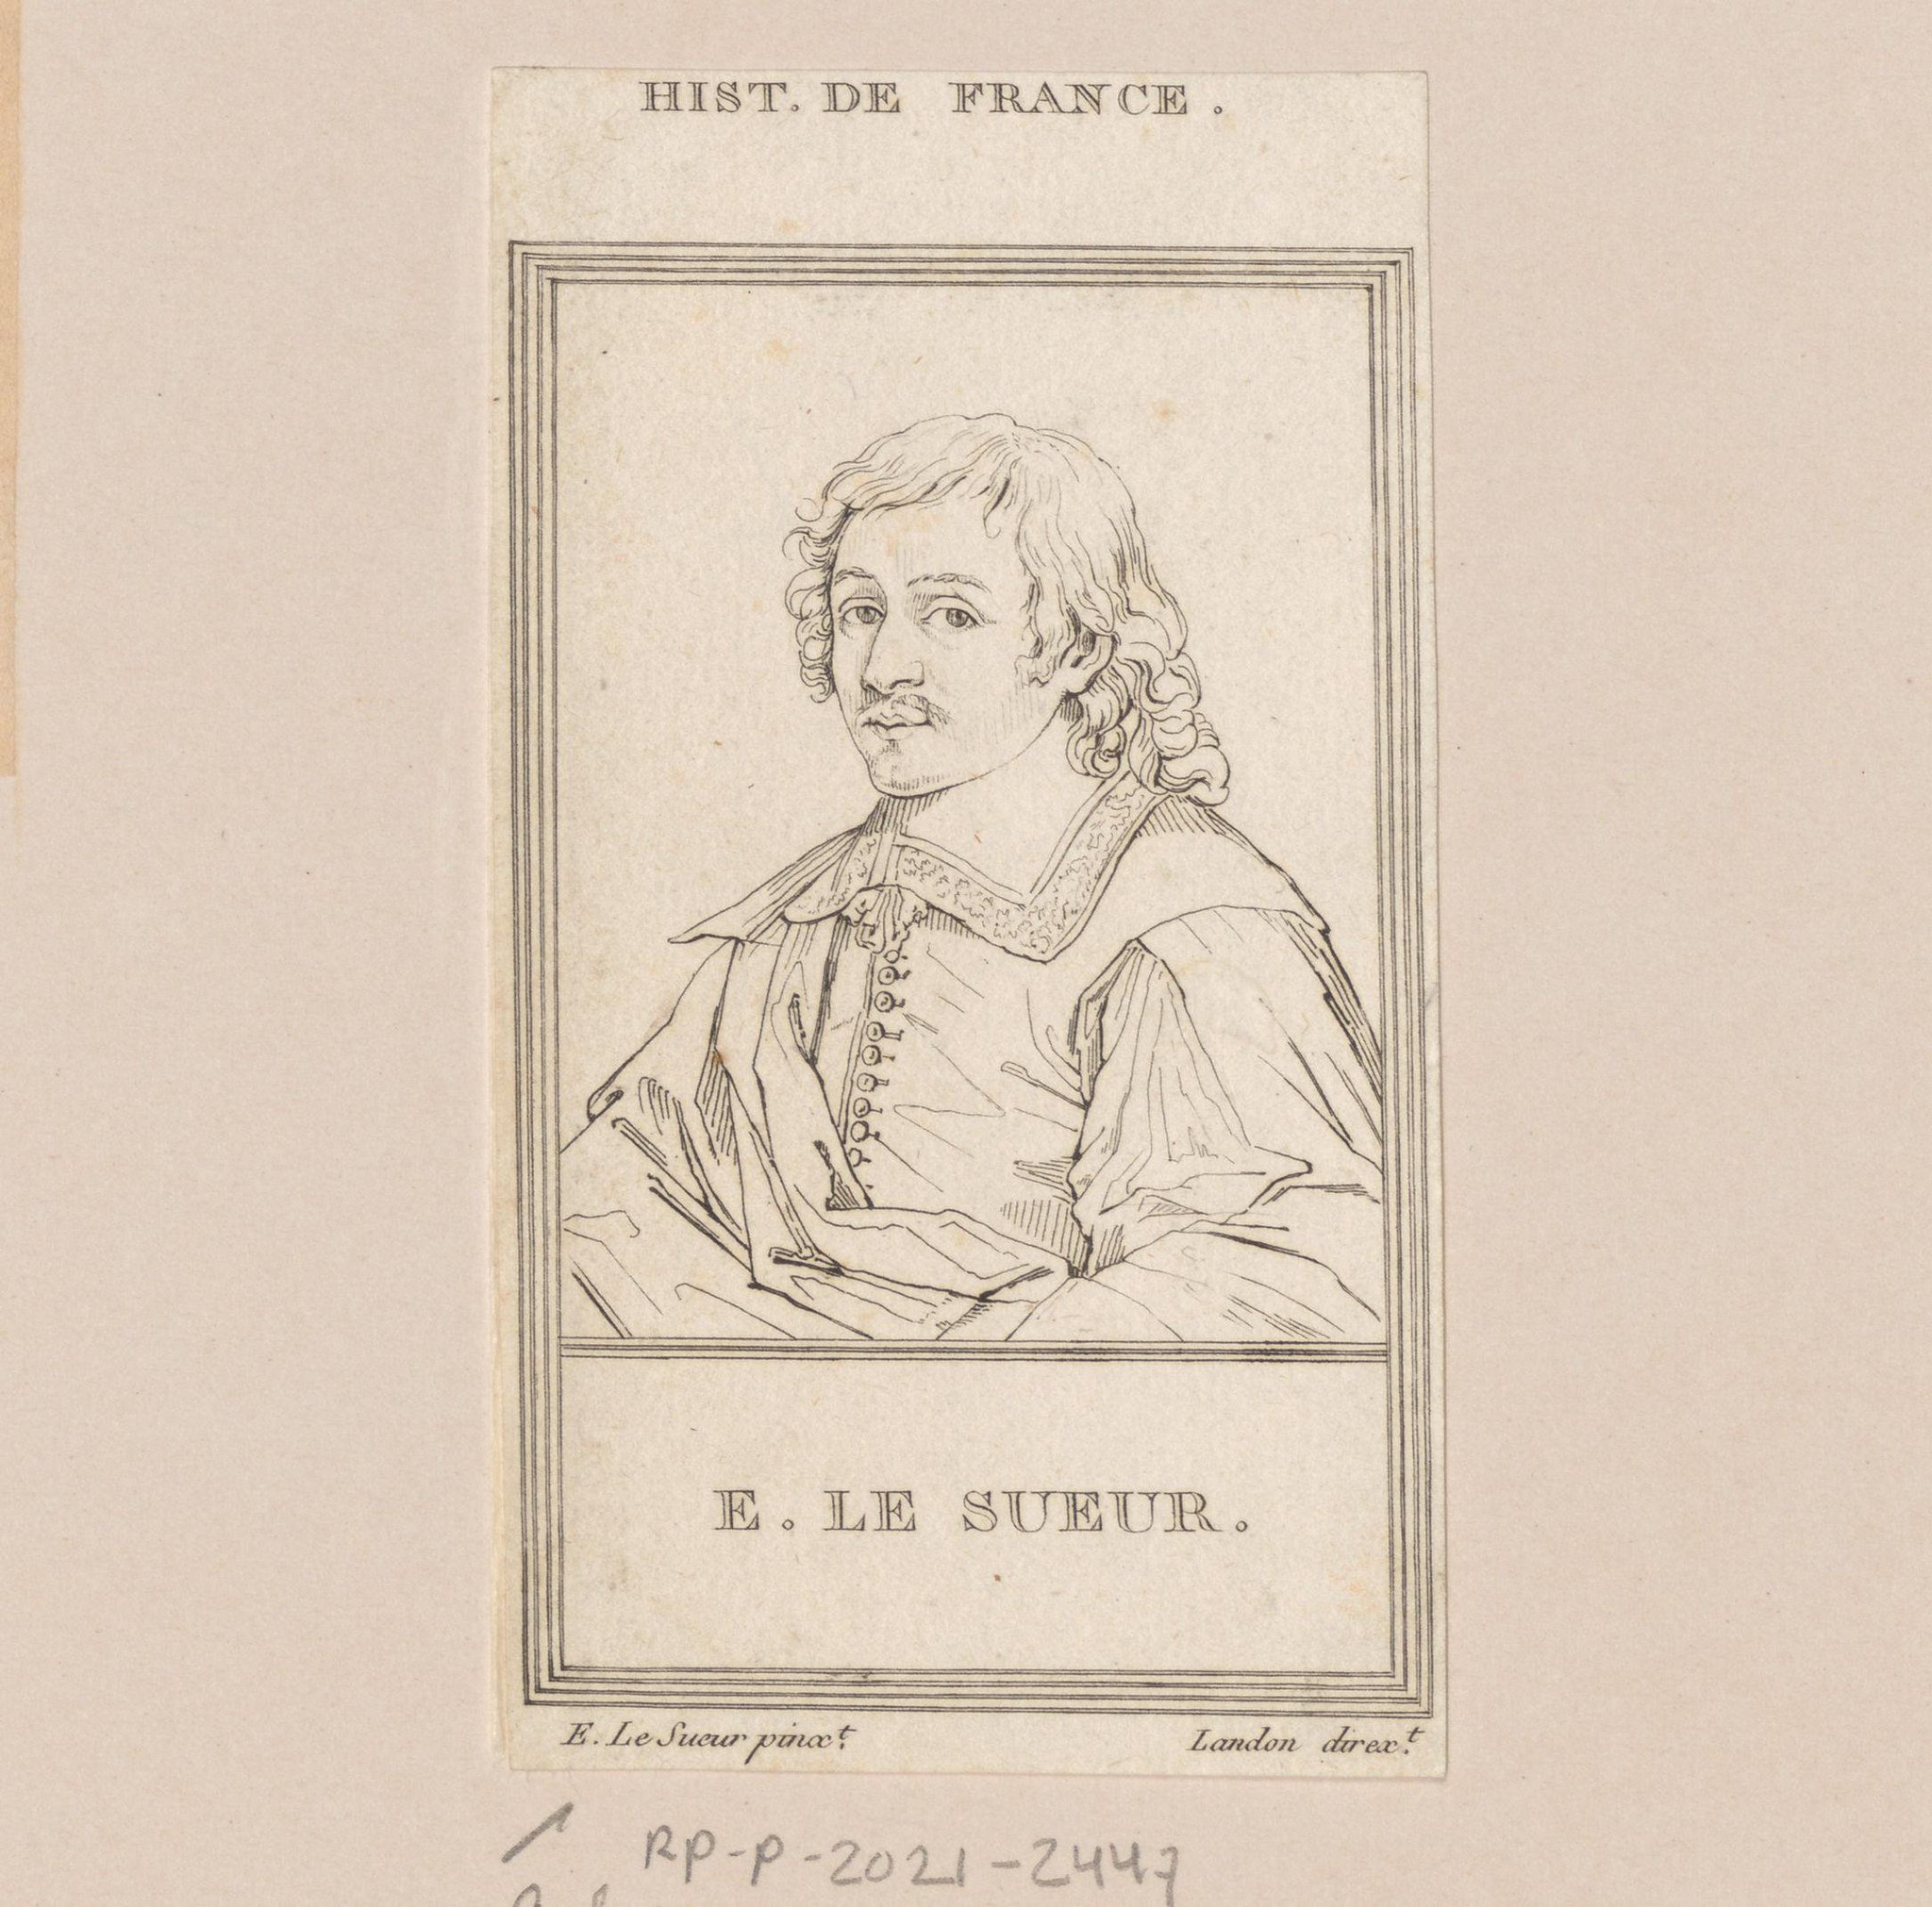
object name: print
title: Portret van Eustache Lesueur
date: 1805-1811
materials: paper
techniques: etching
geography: france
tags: paris, painter, eustache lesueur, historical persons, portrait, self-portrait of painter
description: Prent waarschijnlijk uit een deel van: Galerie historique des hommes les plus celebres de tous les nations (...). Parijs: Charles Paul Landon, 1805-1811.